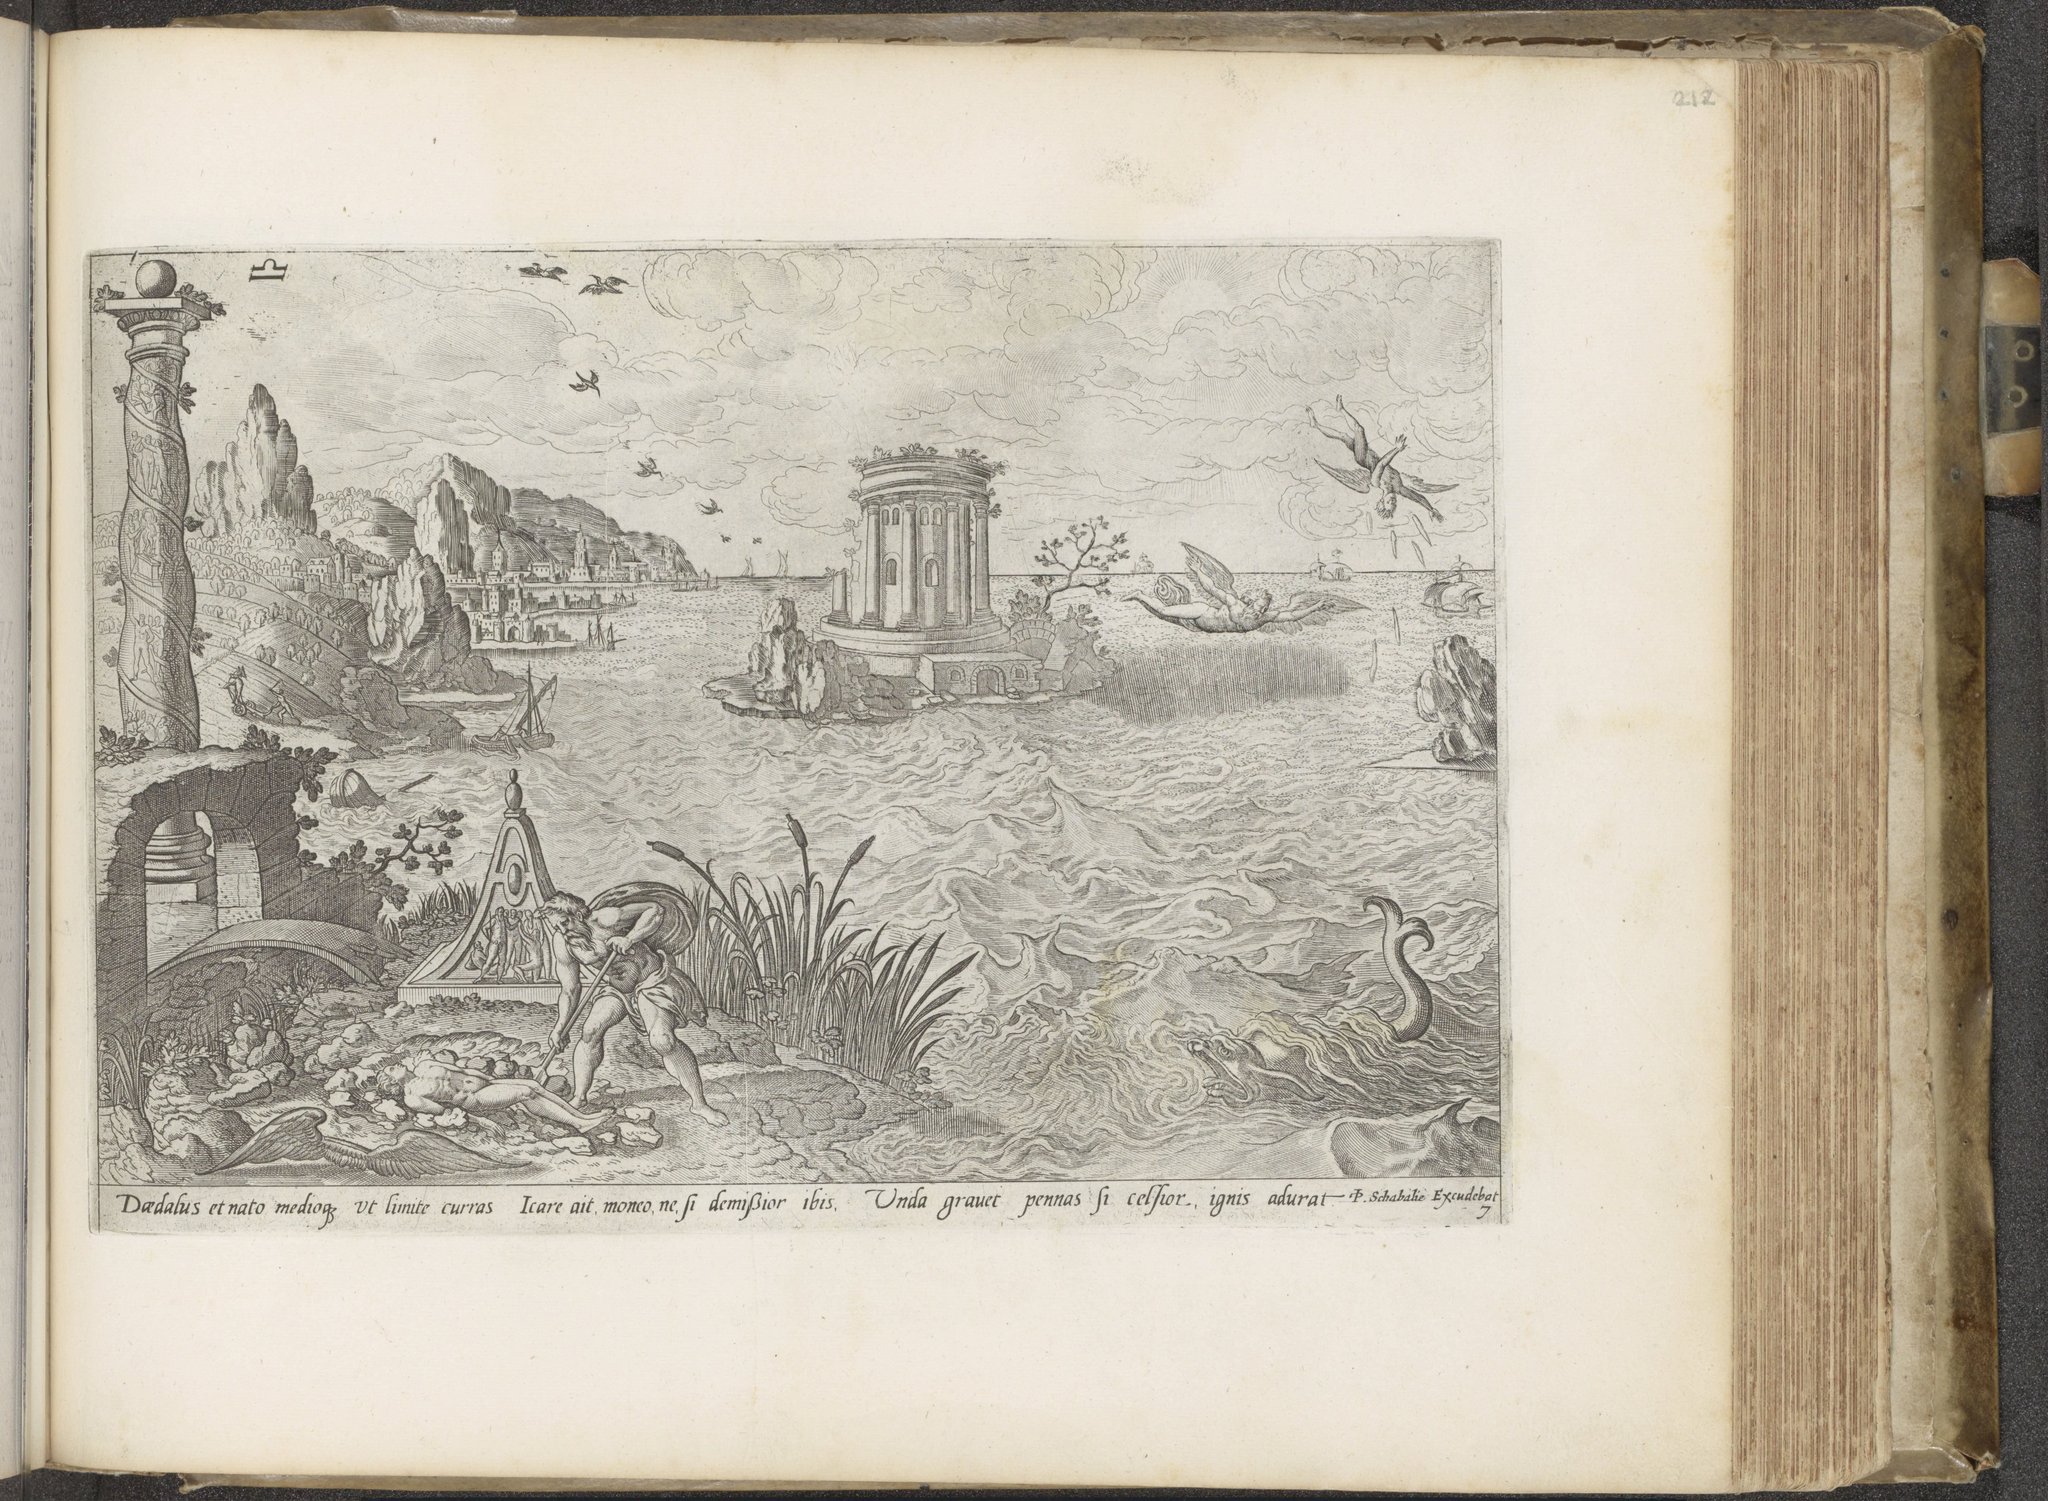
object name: album leaf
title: Den Grooten Emblemata Sacra, bestaande in meer dan vier hondert bybelsche figuren, zoo des Ouden als des Nieuwen Testaments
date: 1653-1654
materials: paper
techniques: etching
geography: antwerp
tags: death i.e. the fall of icarus (daedalus present), libra (zodiacal sign of september), the flight of daedalus and icarus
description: Daedalus en Icarus, vader en zoon, ontsnappen van het eiland Kreta met vleugels die met was aan hun schouders zijn vastgezet. Icarus vliegt te hoog waardoor de zon de was doet smelten. Rechts de val van Icarus. In zee zwemt een zeemonster. Links op de voorgrond begraaft Daedalus zijn zoon Icarus. Onder de voorstelling een tekst uit de Metamorfosen van Ovidius, boek 8, versregel 203-205. Bovenaan het teken van de Weegschaal uit de dierenriem. De prent maakt deel uit van een album.